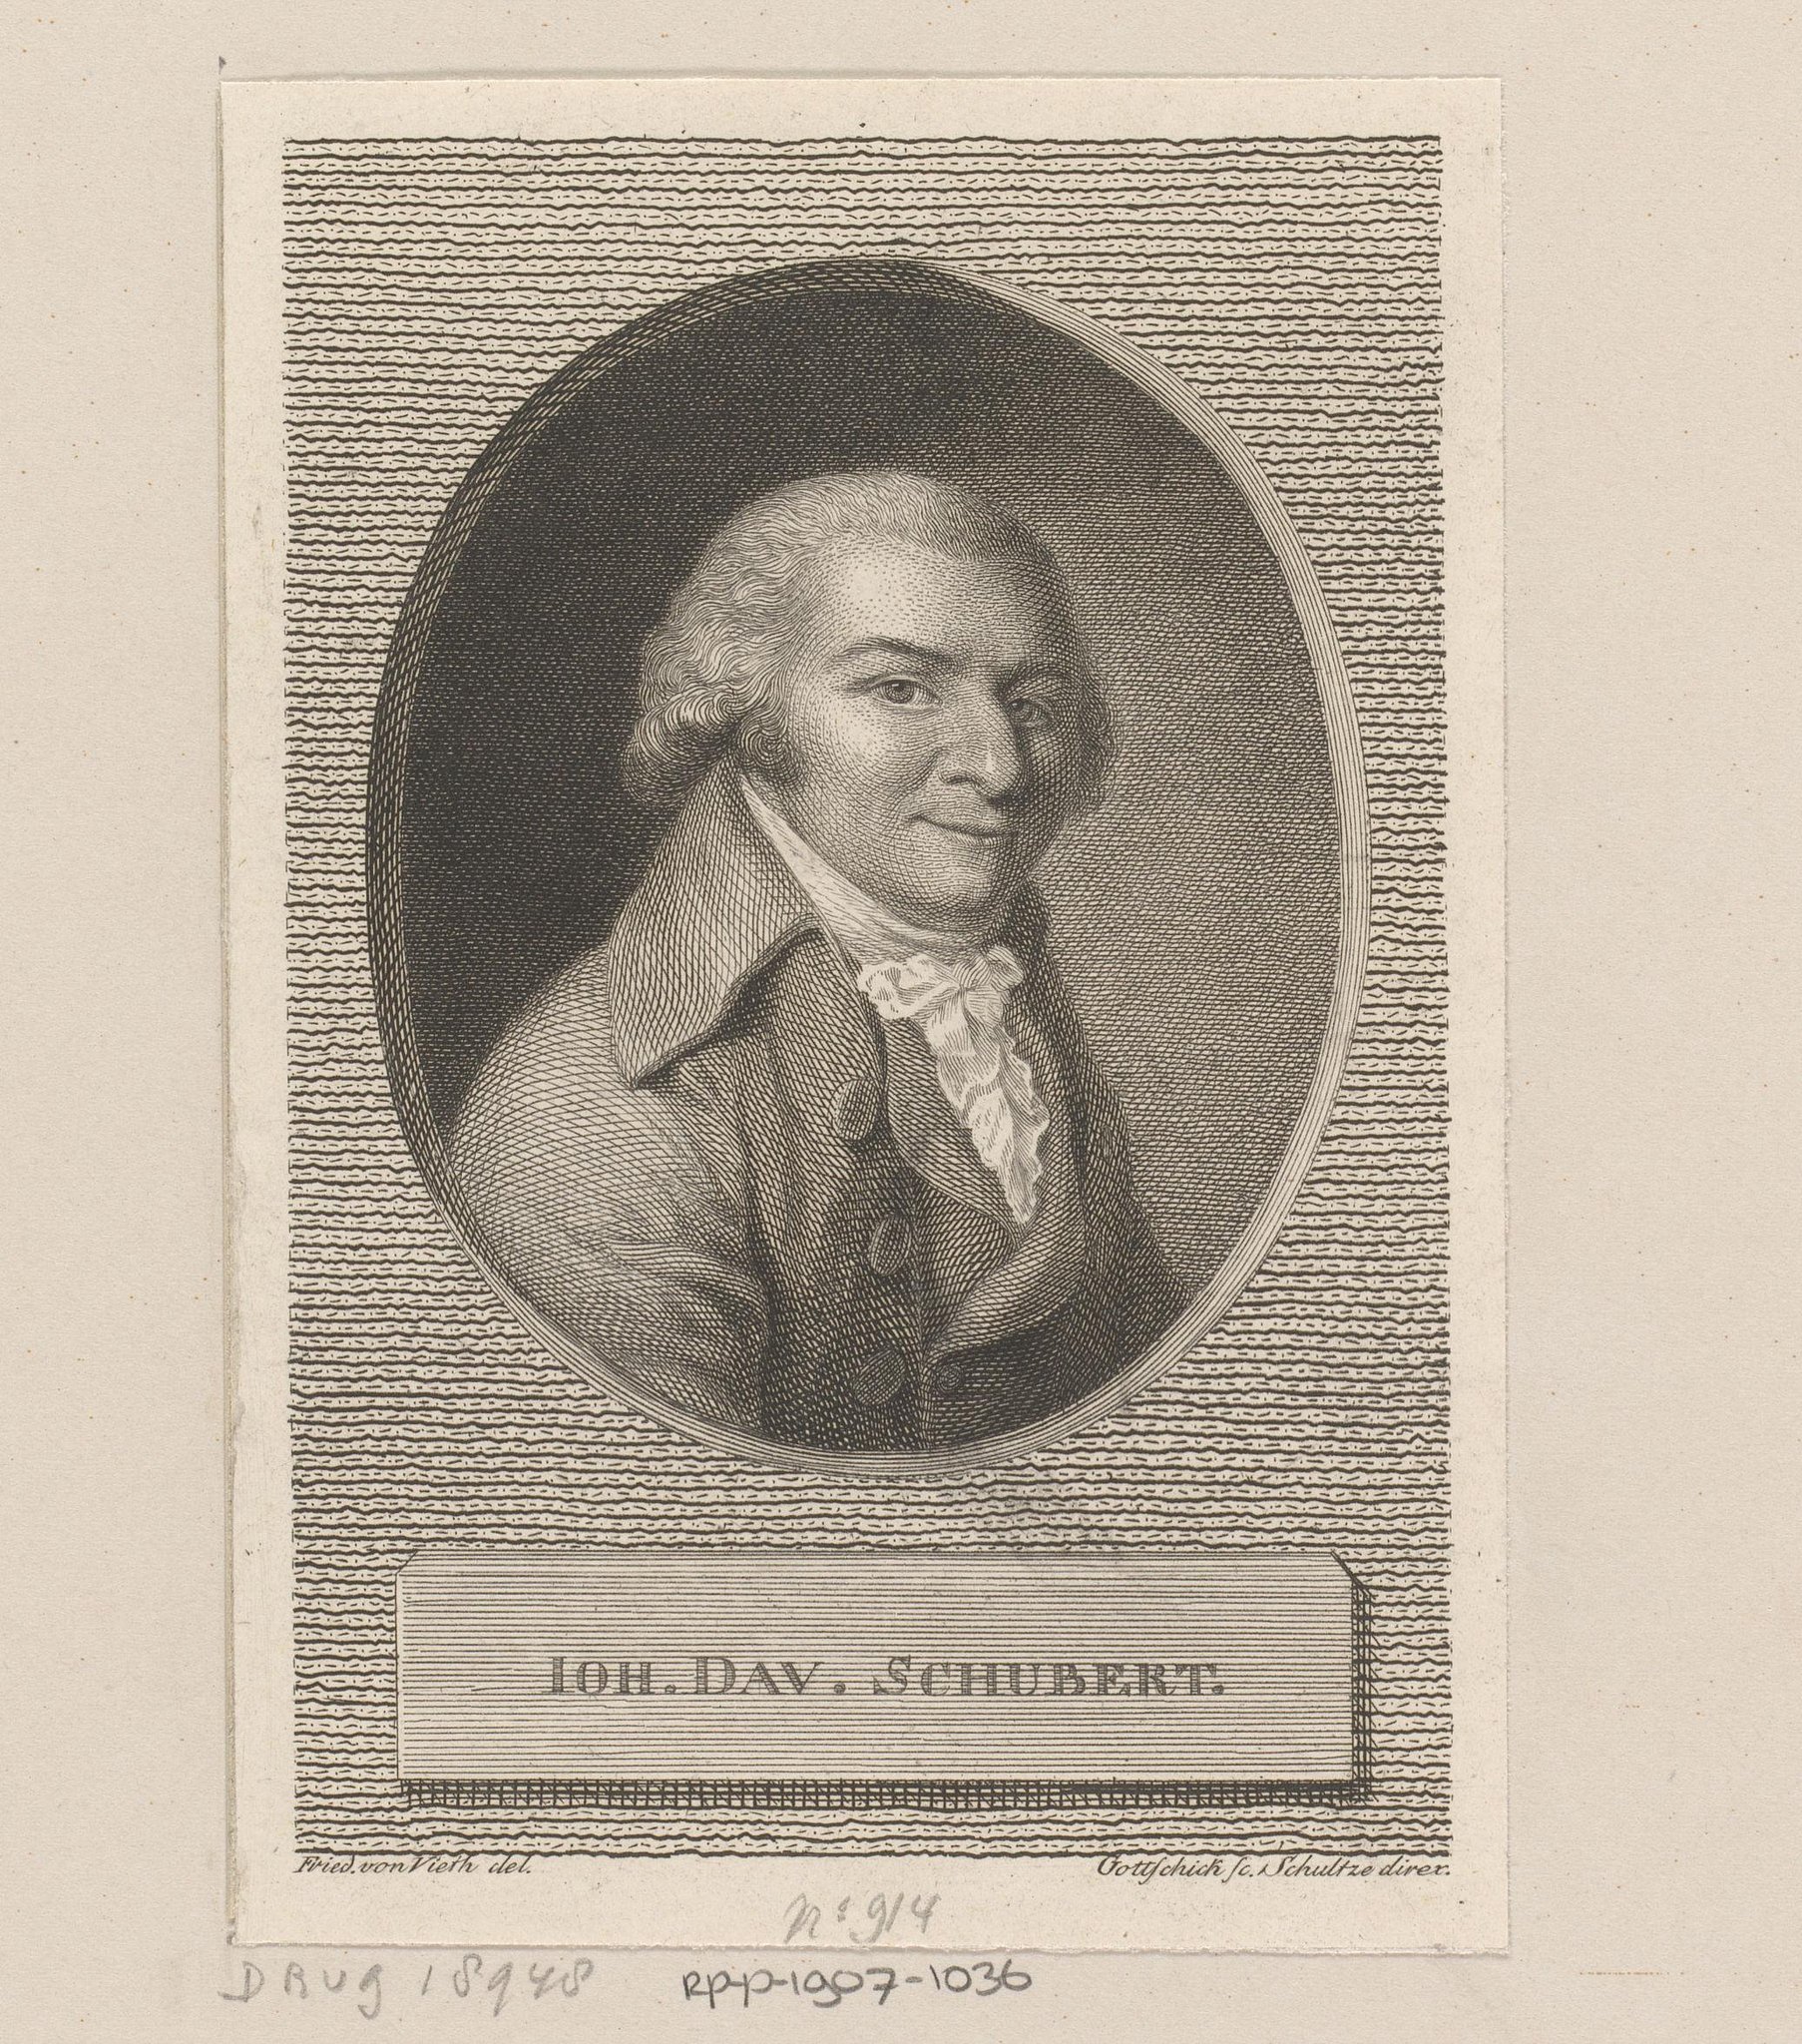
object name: print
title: Portret van Johann David Schubert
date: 1797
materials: paper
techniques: engraving, etching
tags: painter, print maker, draughtsman, historical persons, portrait, self-portrait of artist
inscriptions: collector's mark: Lugt 2228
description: Prent waarschijnlijk uit: Neue Bibliothek der schönen Wissenschaften und der freyen Künste. Leipzig: Johann Gottfried Dyck, 1797, dl. 59.